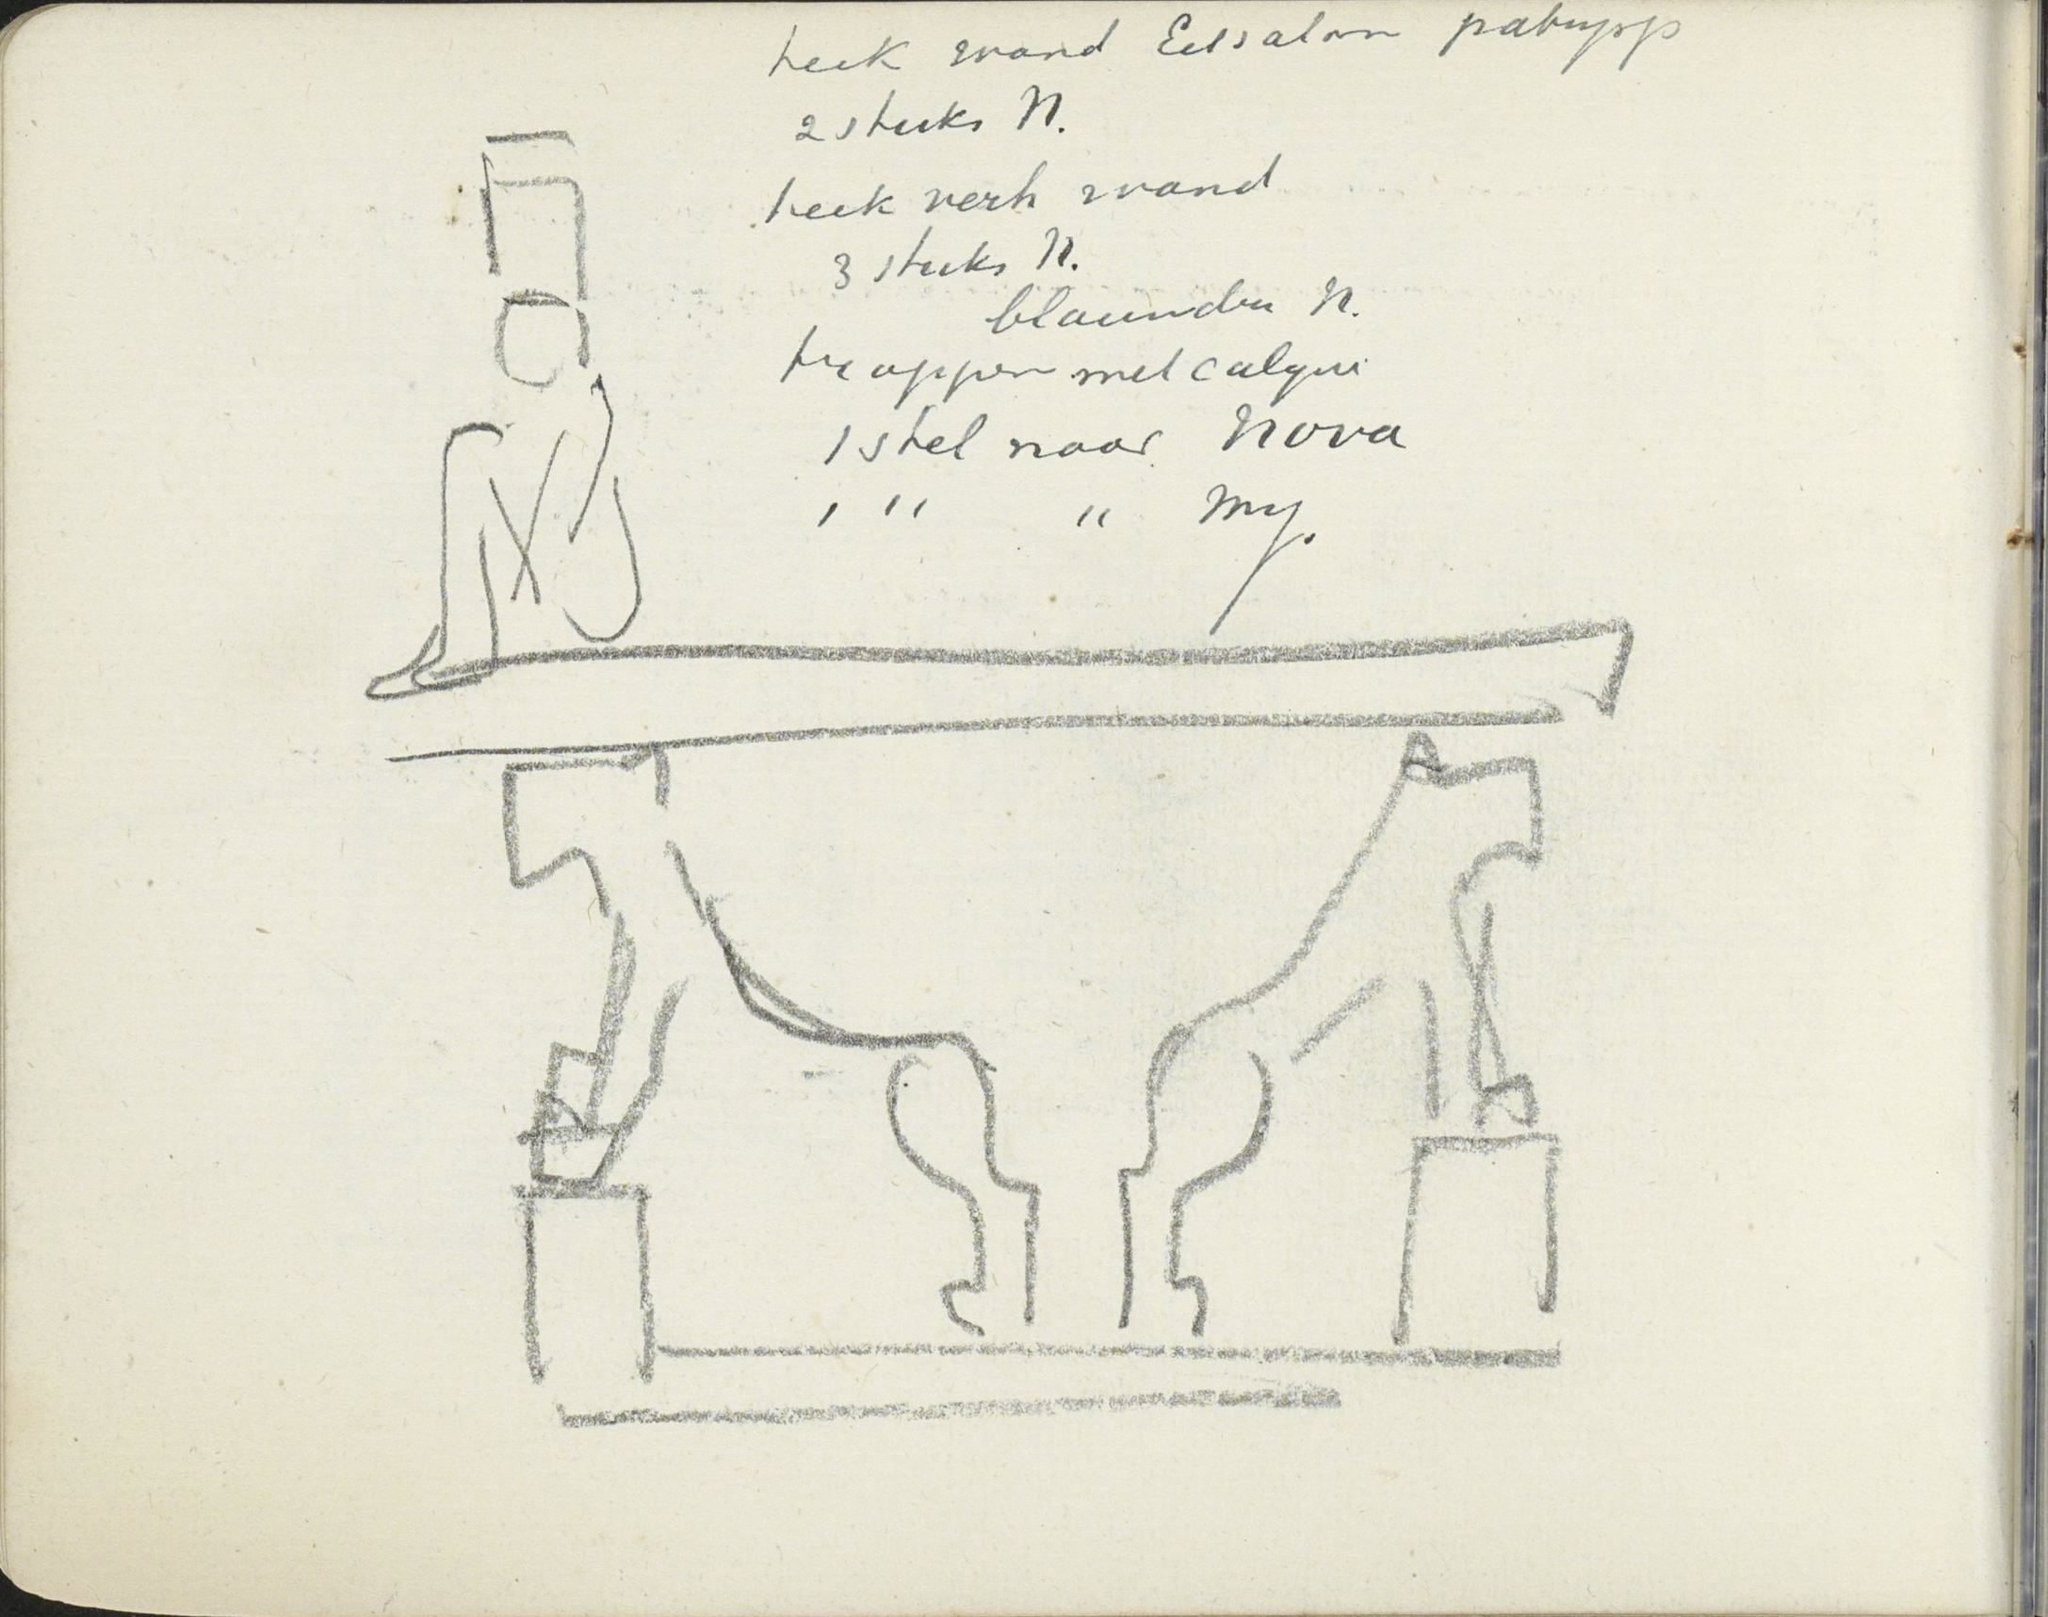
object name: sketchbook leaf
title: Ontwerp voor een tafel met dierlijke ornamenten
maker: carel adolph lion cachet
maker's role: draughtsman, print maker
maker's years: 1864-1945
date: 1928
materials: paper, pencil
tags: ornaments ~ art, table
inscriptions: annotation: ‘teek wand Eetsalon pabuy[...]’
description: Blad 5 verso uit een schetsboek met 24 bladen.